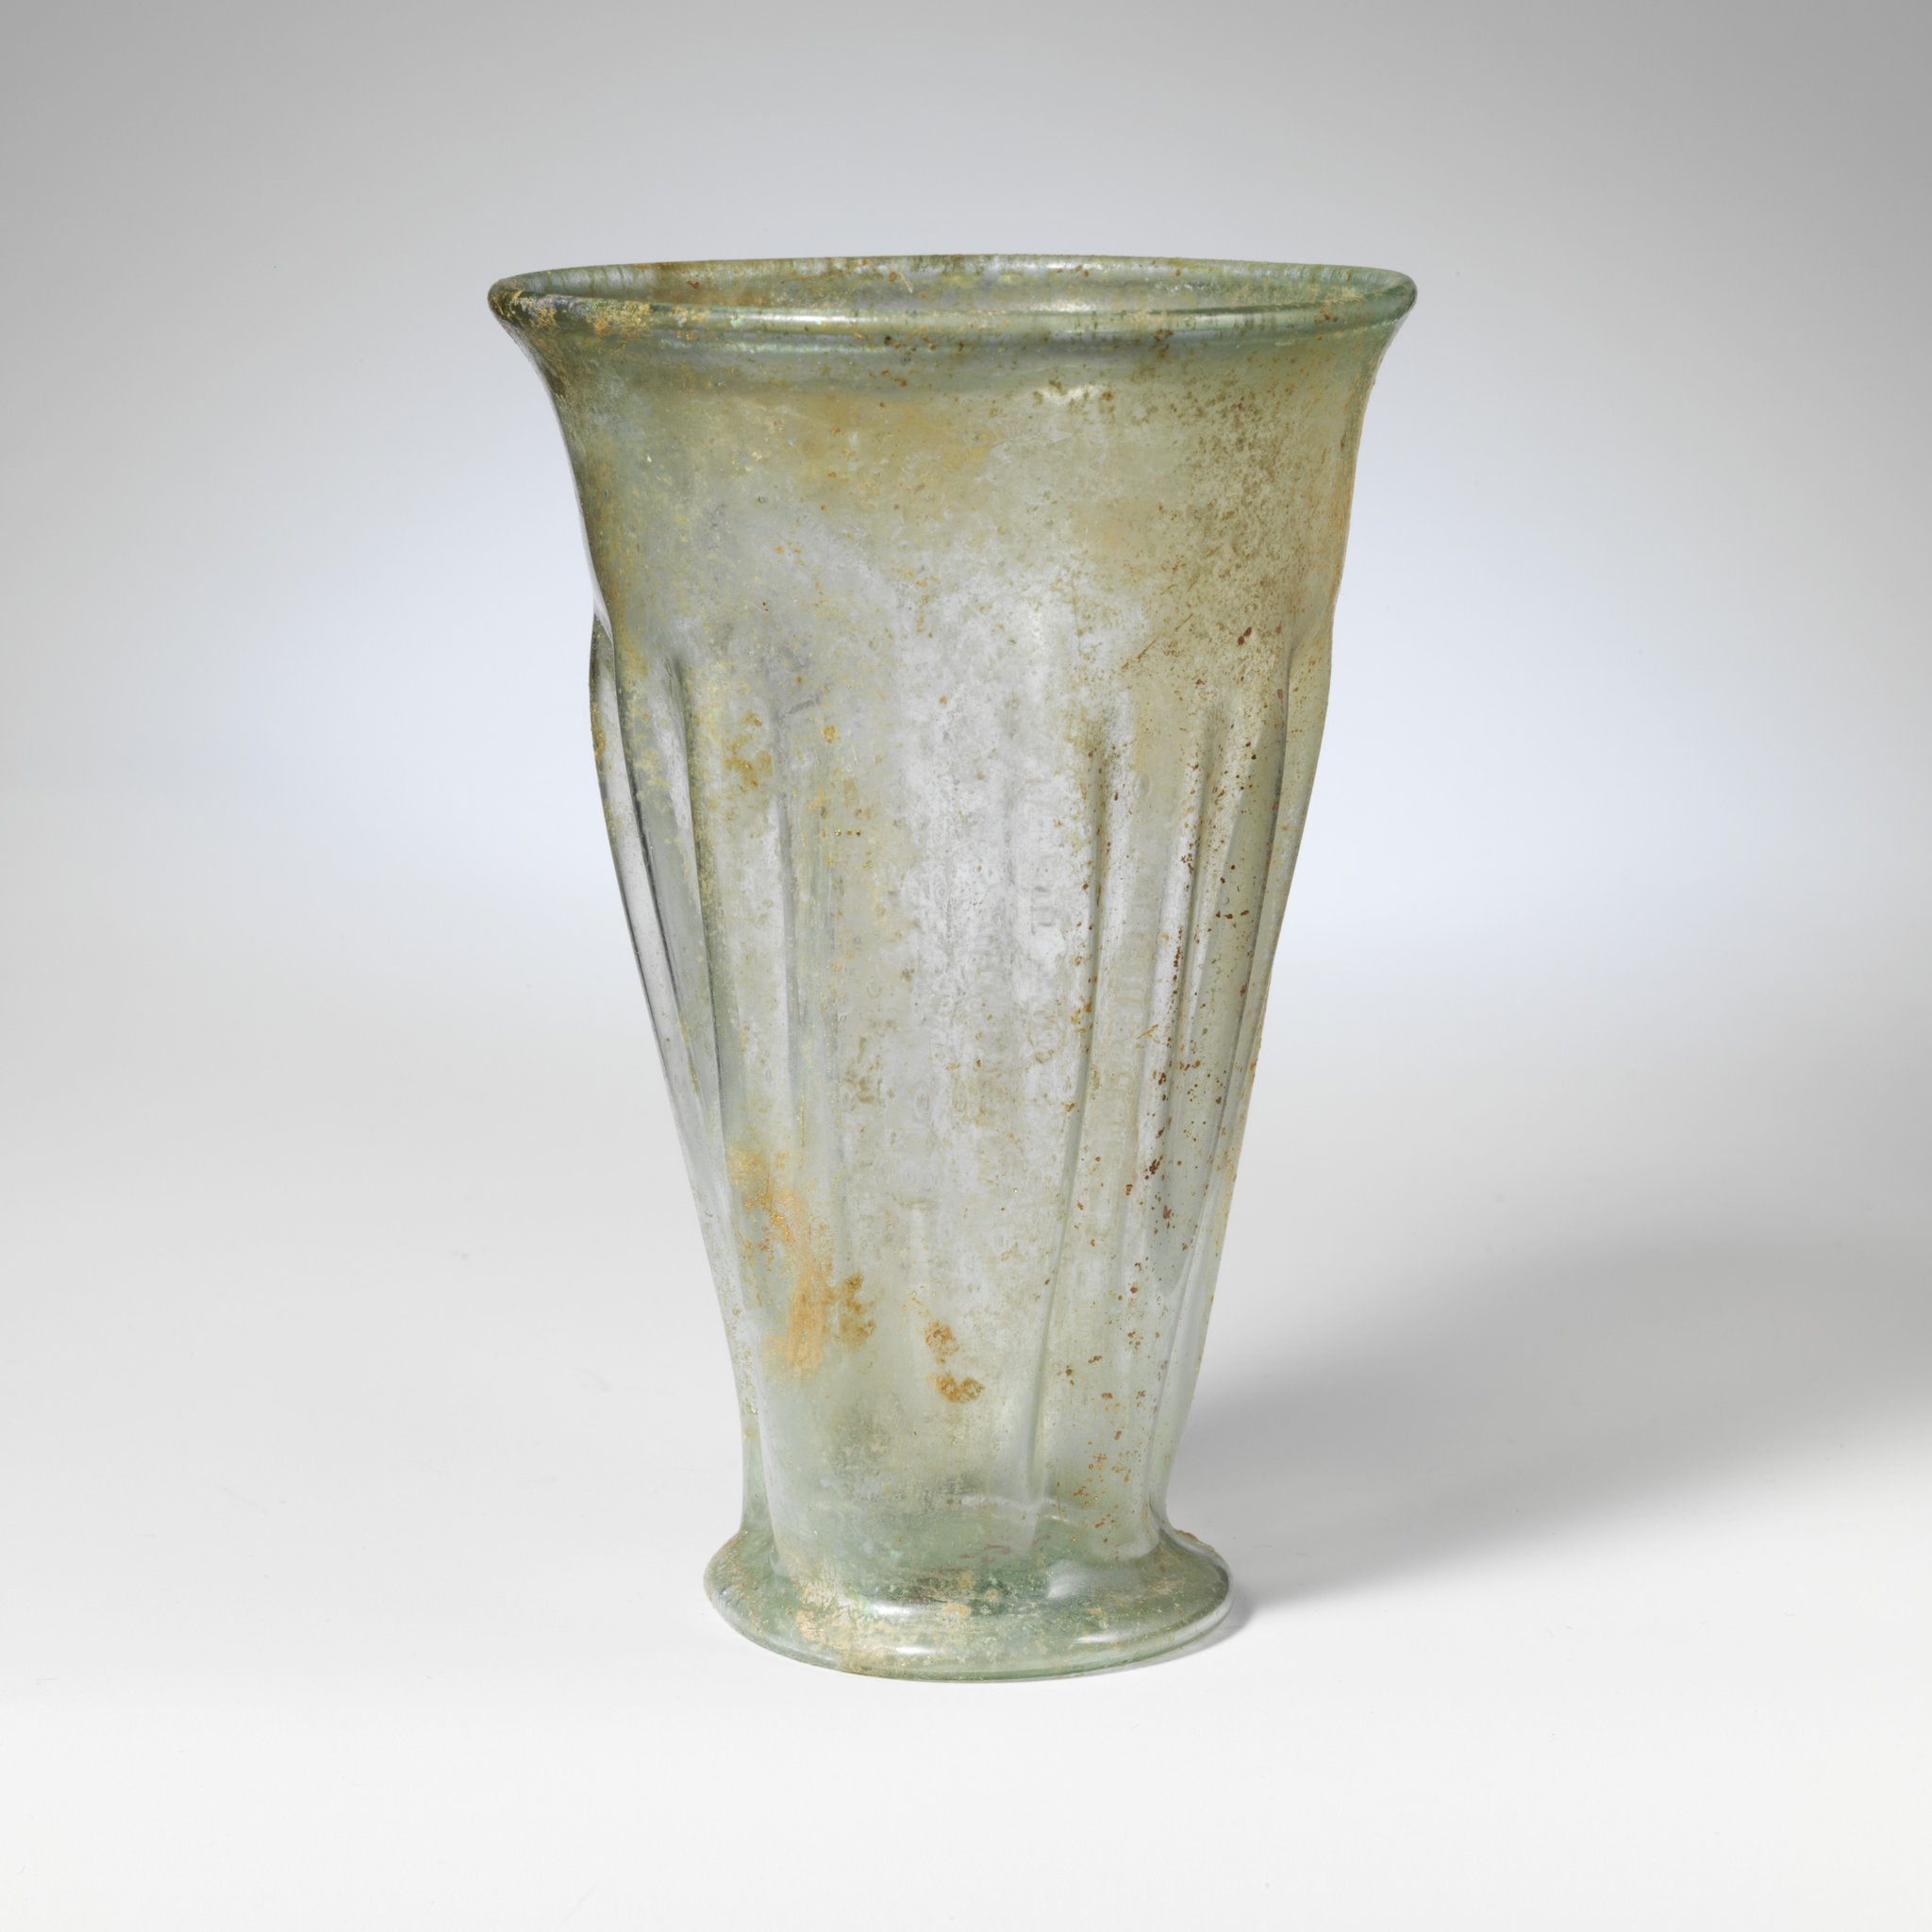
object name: beaker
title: Glass beaker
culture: roman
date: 101-300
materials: glass